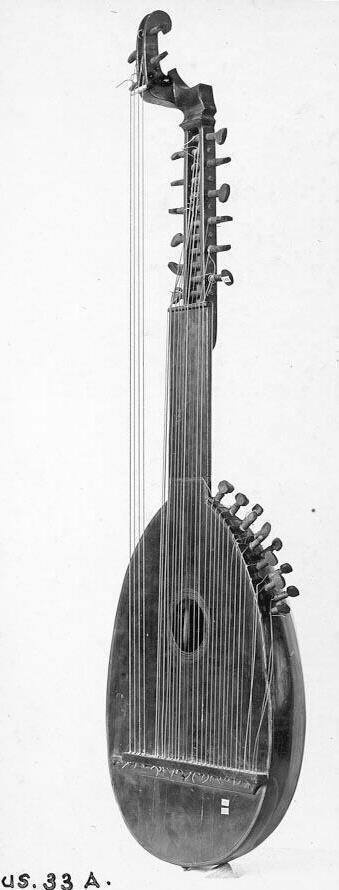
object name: torban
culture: ukrainian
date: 1801-1900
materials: metal, wood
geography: ukraine